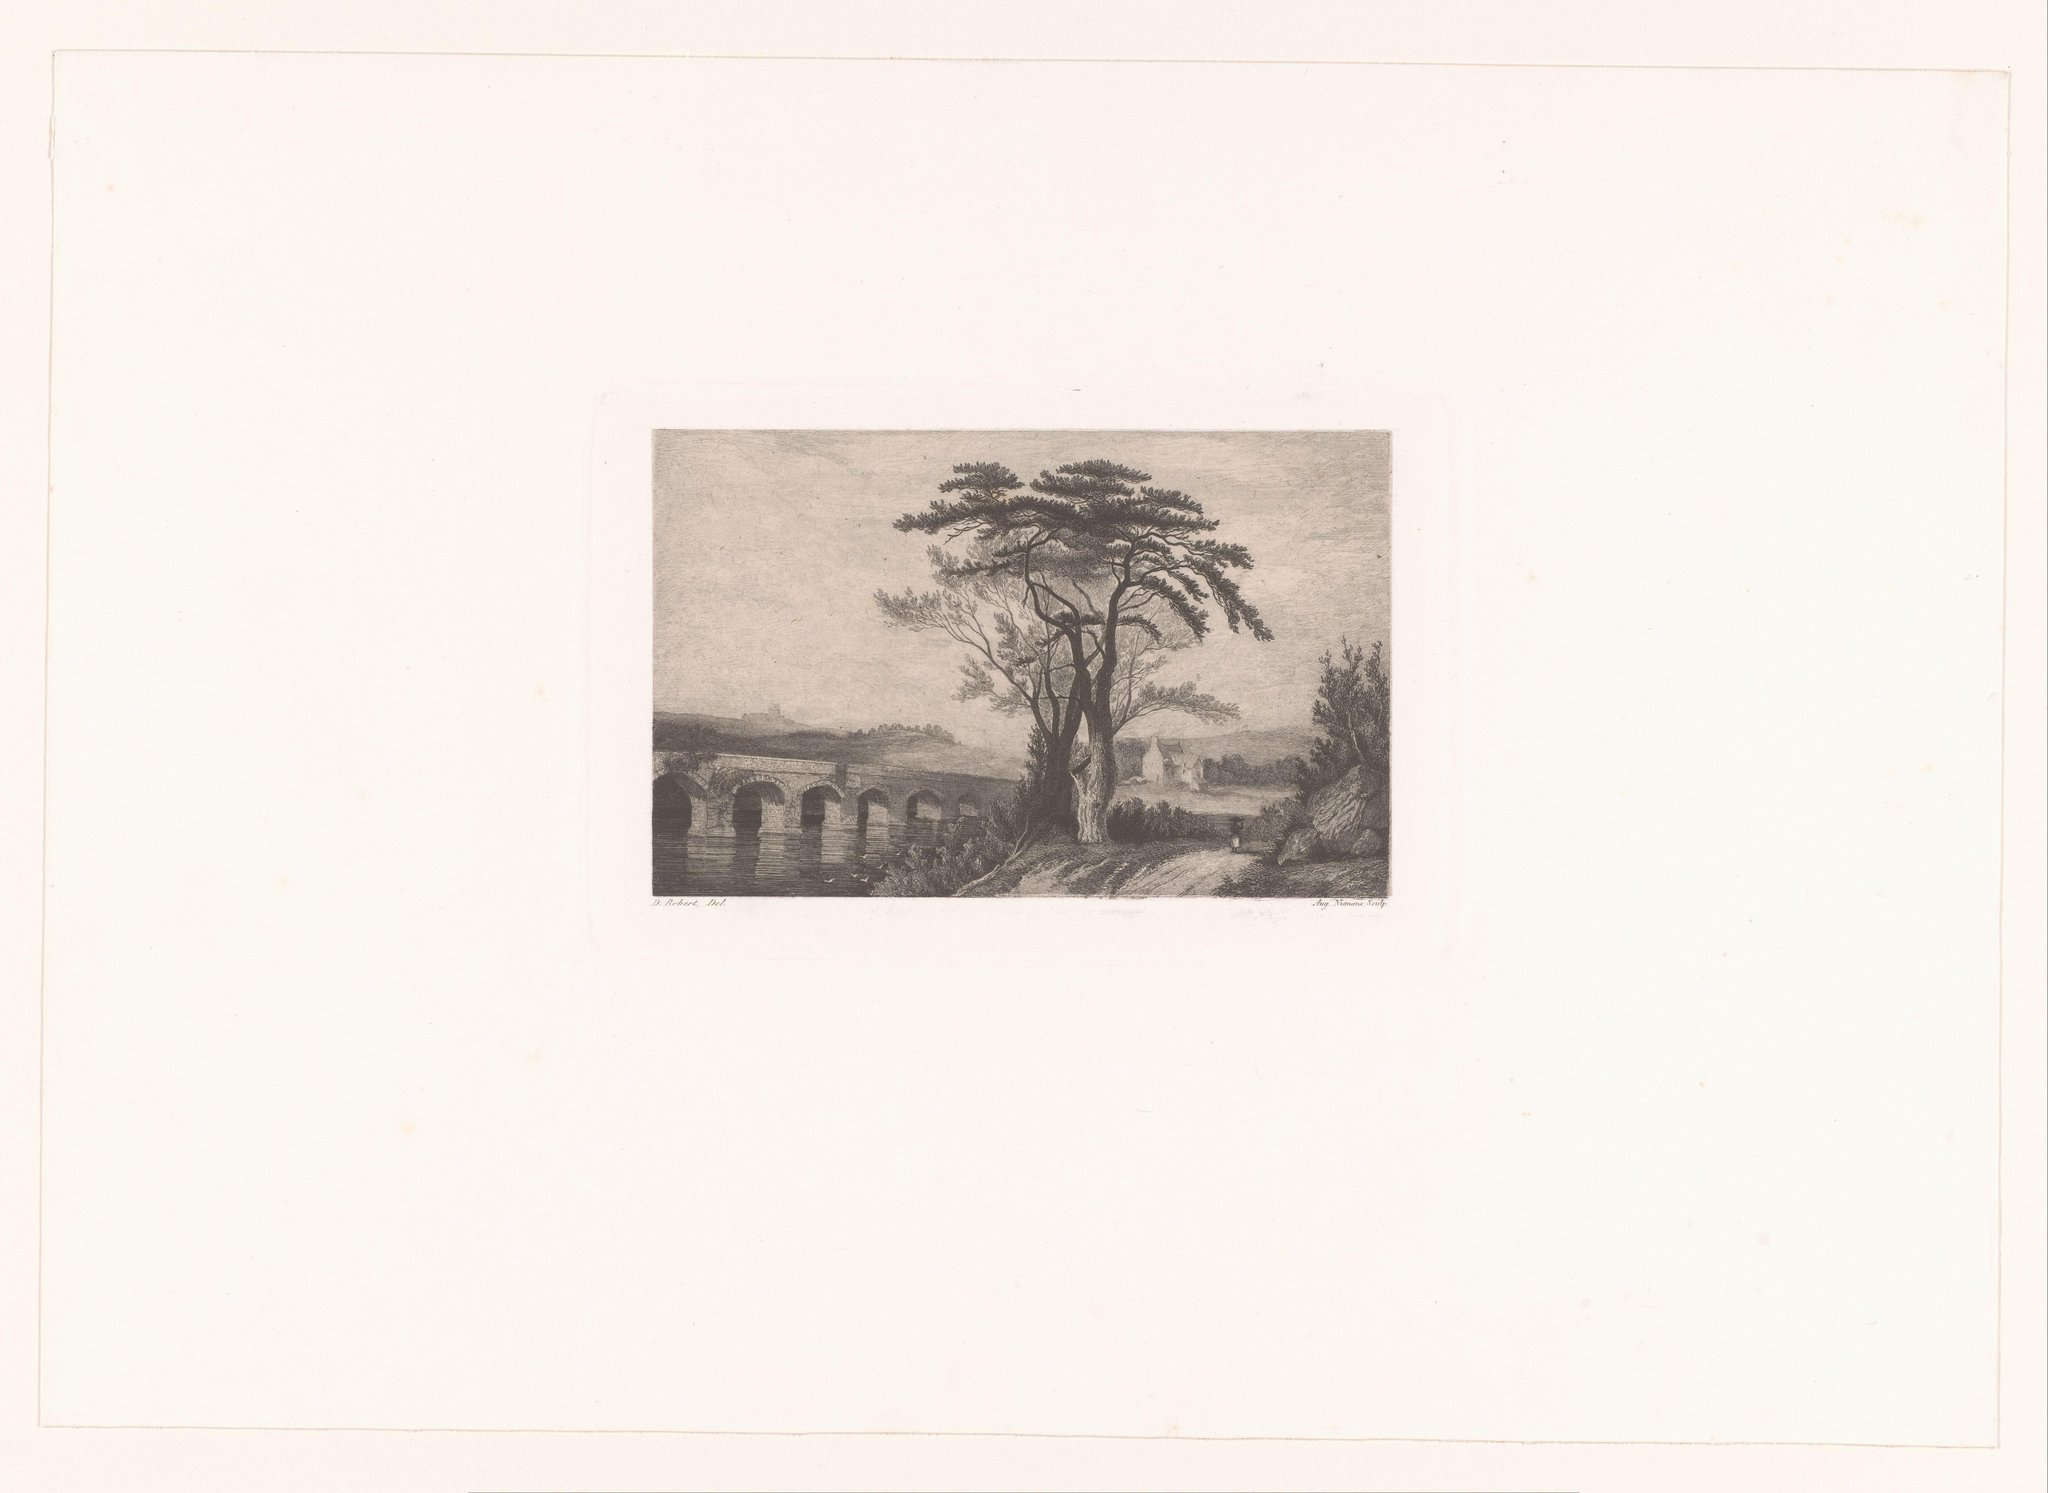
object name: print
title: Berglandschap met stenen brug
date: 1833-1879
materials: paper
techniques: etching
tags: landscape with bridge, viaduct or aqueduct (+ city(-scape) with figures, staffage)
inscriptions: collector's mark: Lugt 2228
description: Deze prent behoort tot een prentserie met diverse landschappen in prent gebracht door Auguste Numans naar voorbeelden van andere kunstenaars.